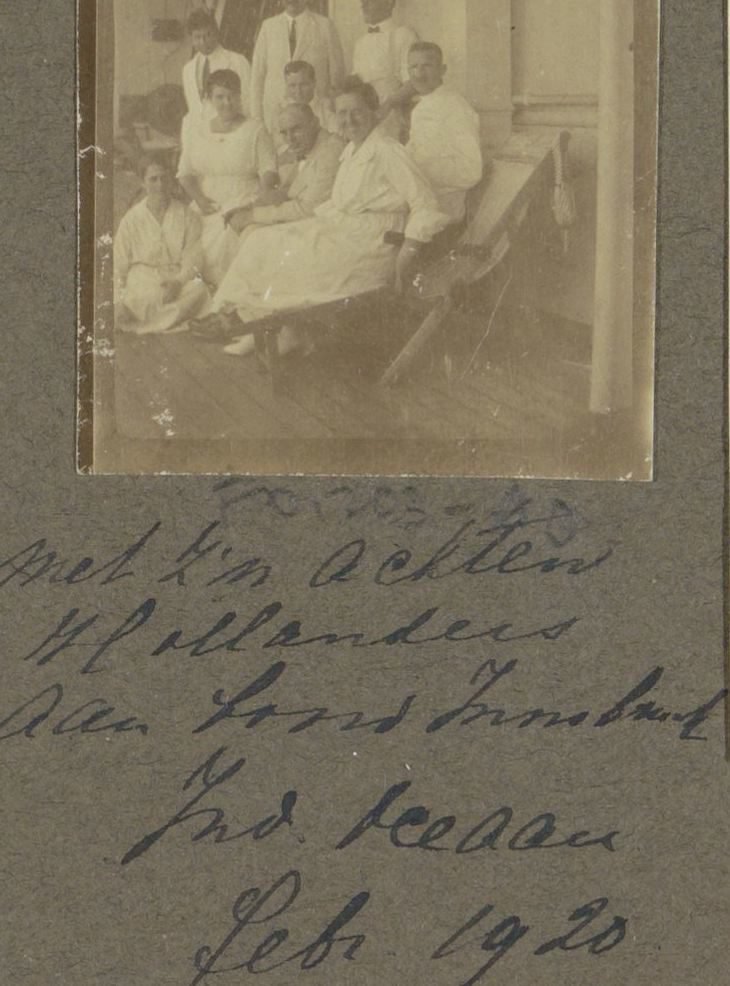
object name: photograph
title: Met z'n achten Hollanders aan boord Innsbruck Ind. Oceaan febr. 1920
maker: Anonymous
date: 1902-1920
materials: photographic support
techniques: daylight paper print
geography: indian ocean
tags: adult woman, passenger liner (+ view ~ vehicle, ship, etc.), adult man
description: Onderdeel van fotoalbum van een onbekende Nederlandse familie met opnames van Suriname, Europa en Nederlands-Indië.